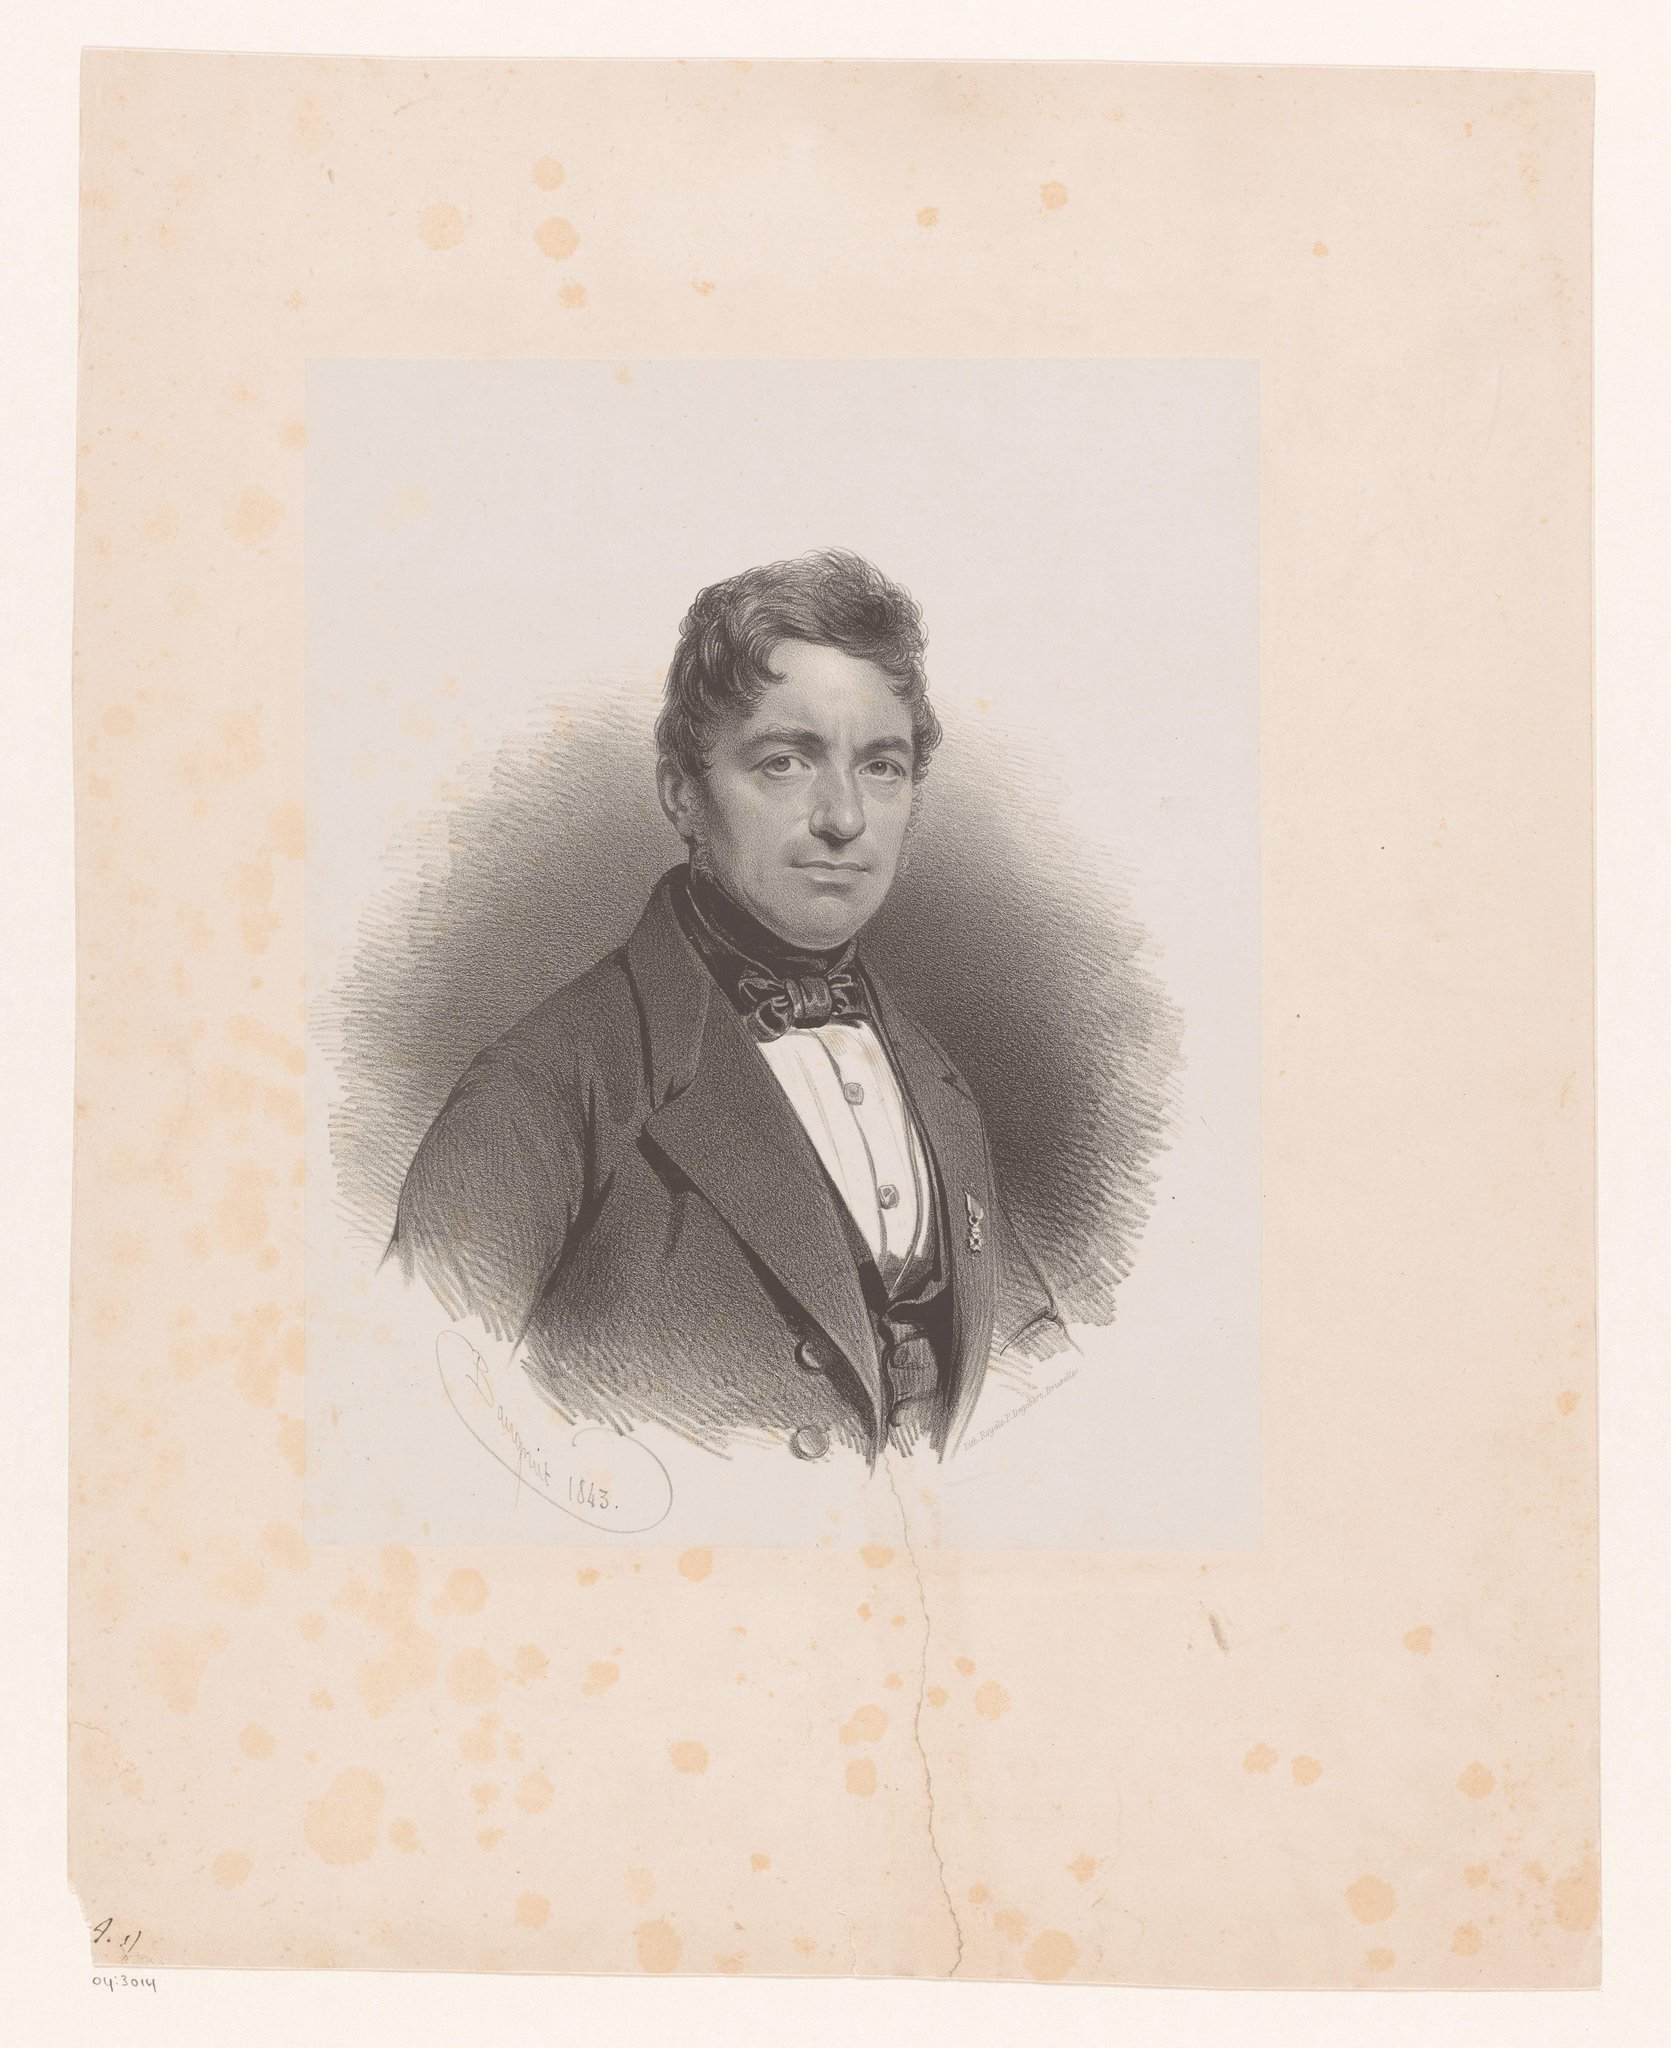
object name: print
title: Portret van een onbekende man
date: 1843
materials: paper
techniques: lithograph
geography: brussels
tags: adult man, historical persons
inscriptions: collector's mark: Lugt 2228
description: De onderscheiding op de jas is de Orde van de Nederlandse Leeuw.